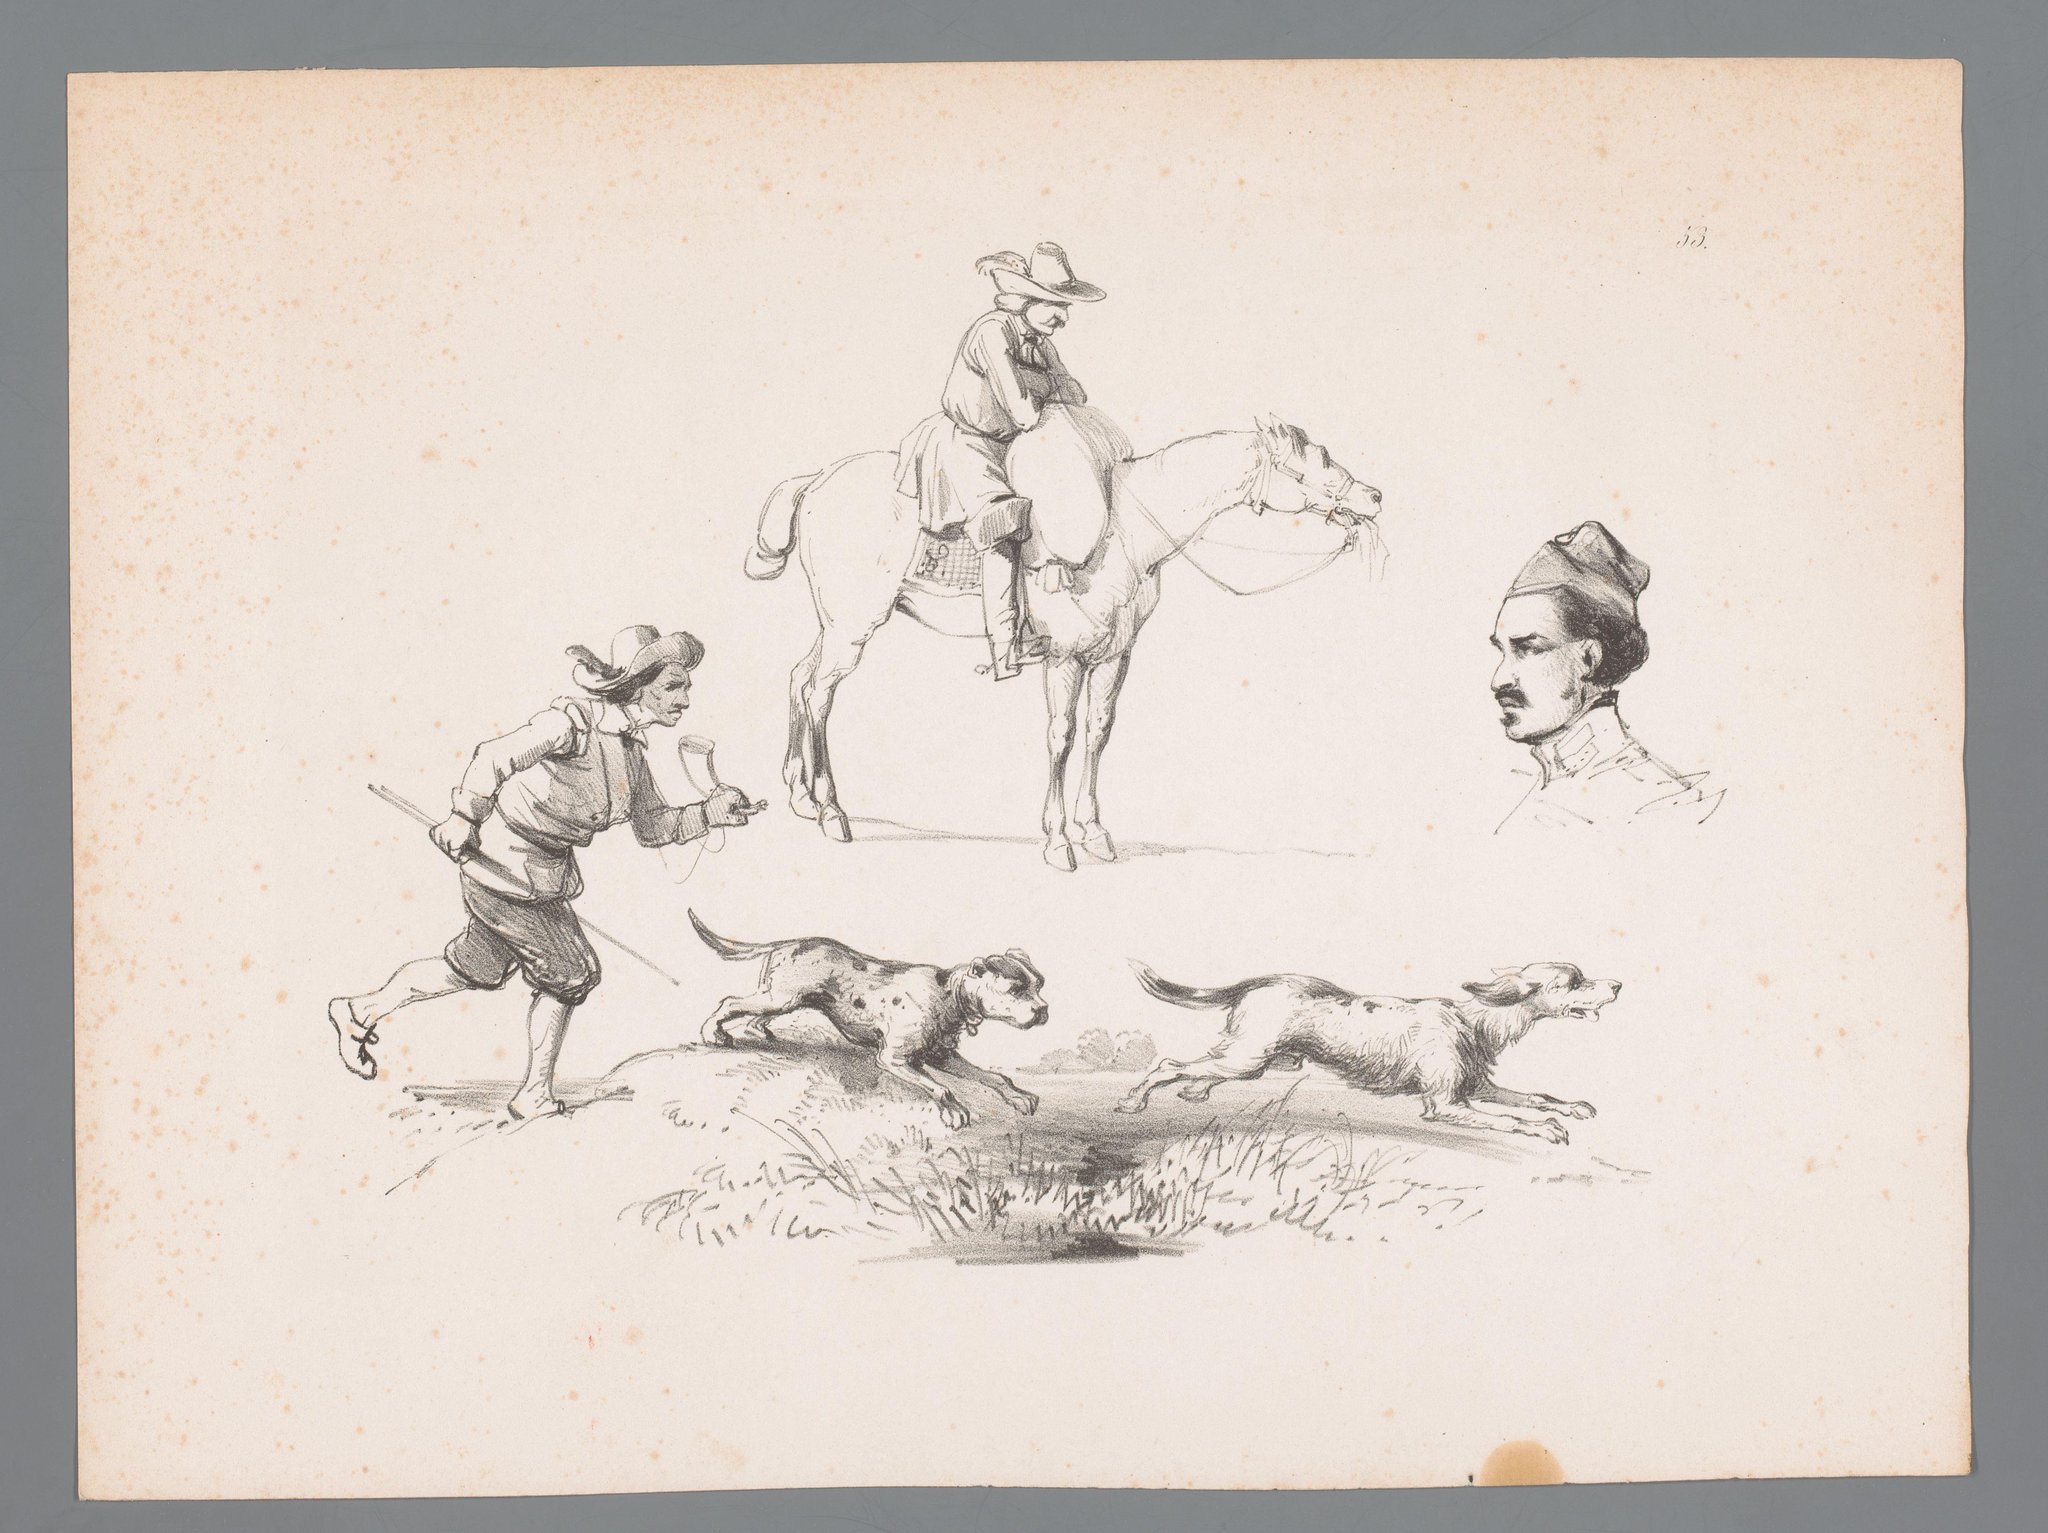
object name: print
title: Figuurstudies van een ruiter te paard, het hoofd van een man en een jager met twee jachthonden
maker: paulus lauters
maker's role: print maker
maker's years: 1806-1875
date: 1816-1875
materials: paper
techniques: lithograph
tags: riding a horse, ass, or mule; rider, horseman, hunting dogs, hunter, adult man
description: Prent maakt deel uit van een serie met figuurstudies. Over deze serie is verder niets bekend.